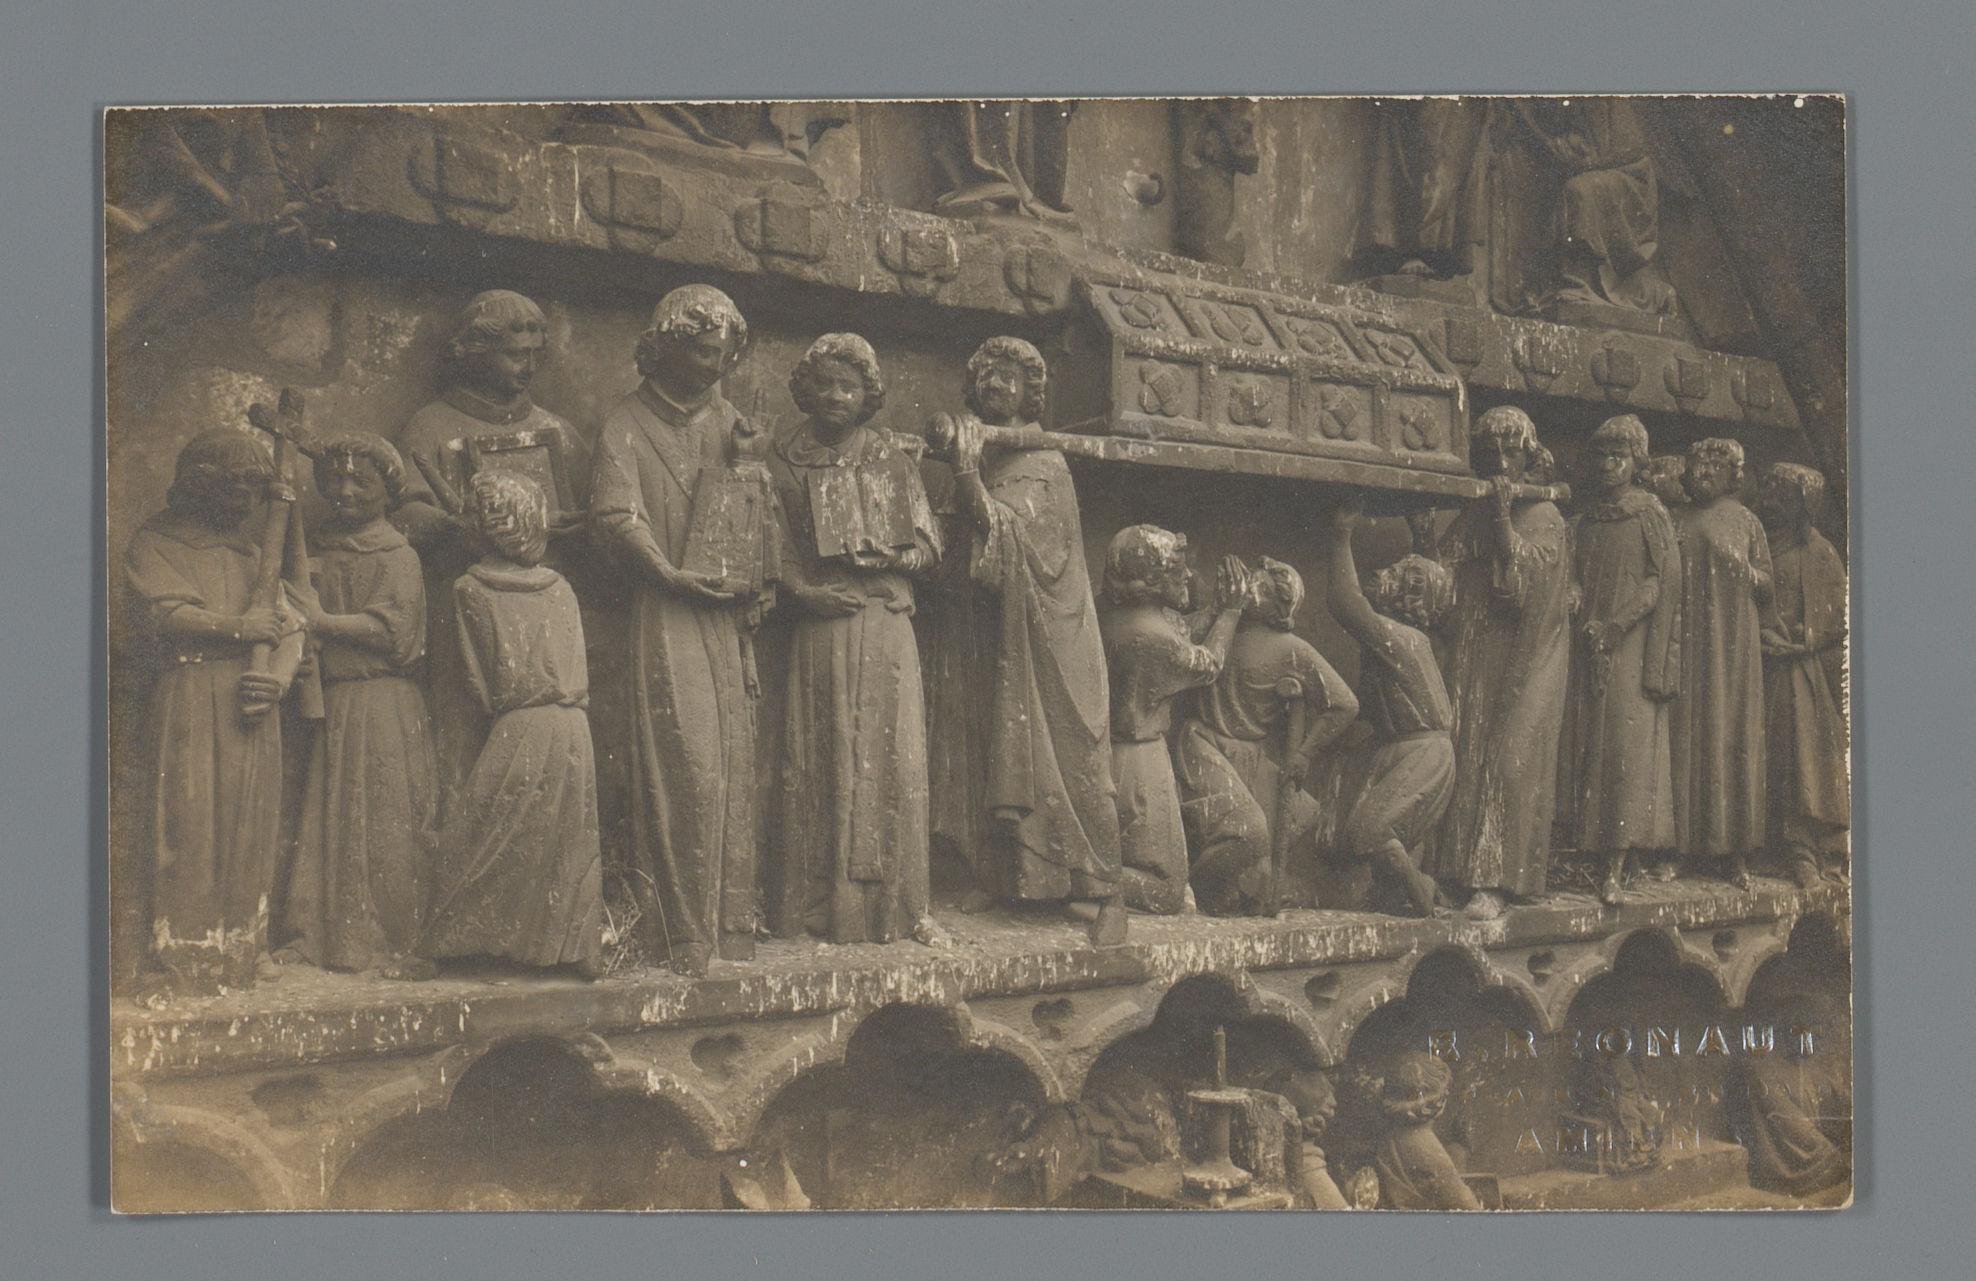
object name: ansichtkaart, prentbriefkaart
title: Beelden aan de façade van de kathedraal van Amiens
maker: Anonymous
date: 1890-1910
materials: paper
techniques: gelatin silver print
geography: amiens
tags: piece of sculpture, reproduction of a piece of sculpture, notre-dame d'amiens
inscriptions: inscription: ‘[...]/ La Renaissance/ 1925/ Bladz. 121./ Amiens Cathedrale/ statues de la façade/ afk. uit apparaat/ H.P. Baart/ juni 2010’, check stamp: ‘E. REGNAUT/ 50 PLACE NOTRE DAME/ AMIENS’